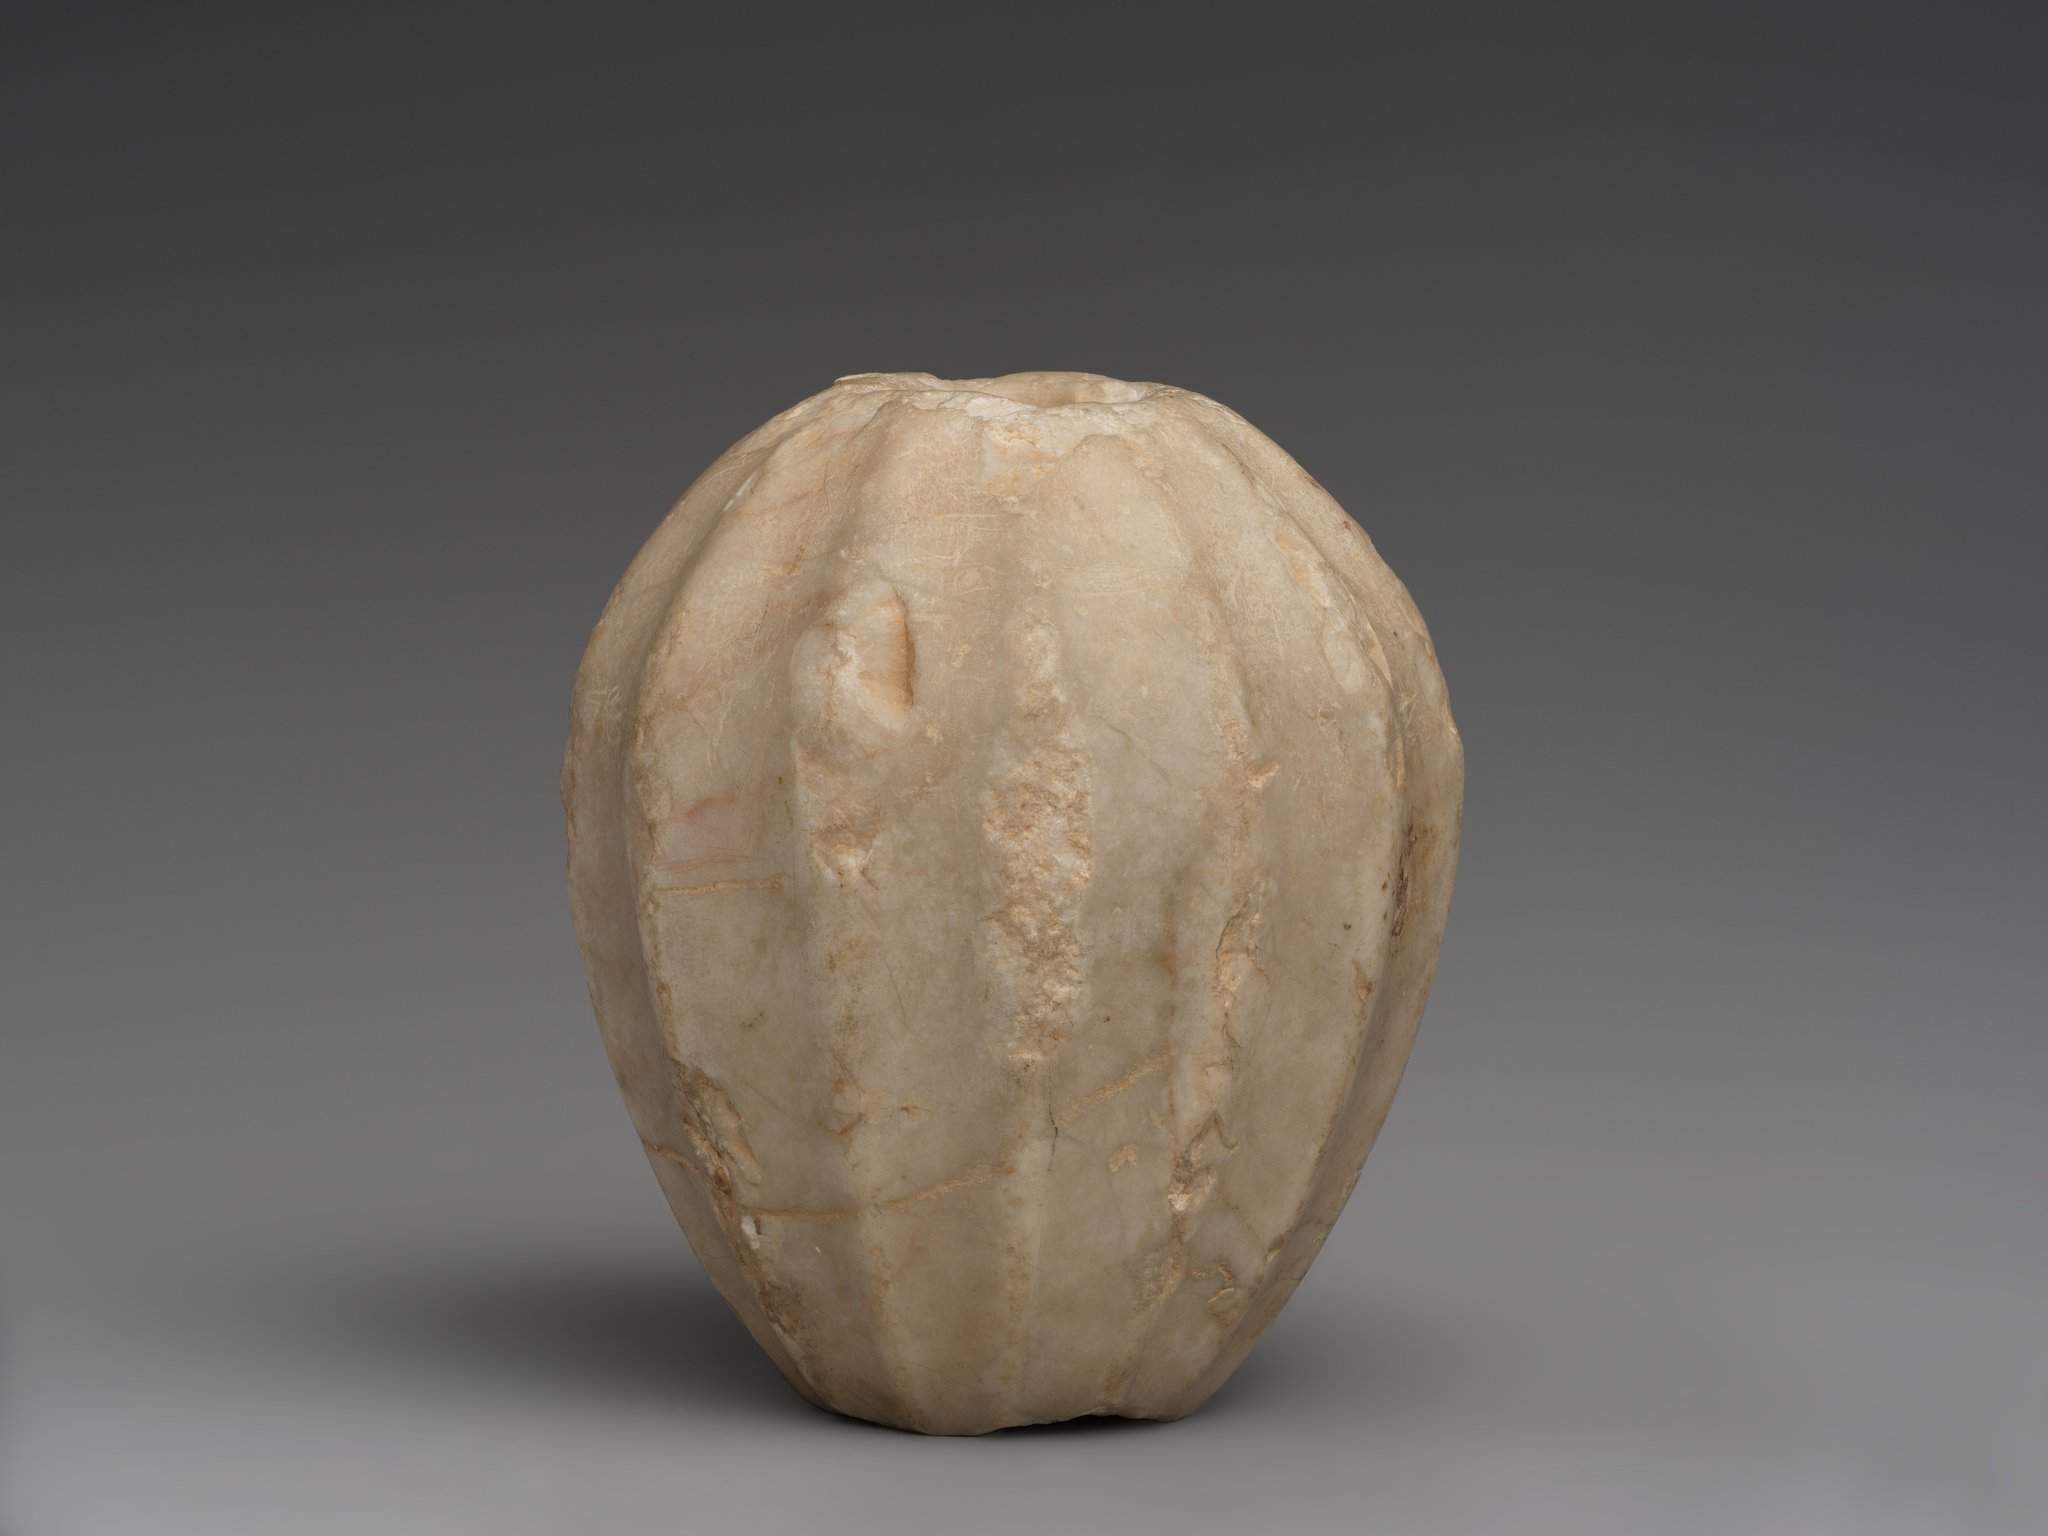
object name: mace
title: Mace head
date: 2700-2600 BCE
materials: stone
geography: mesopotamia